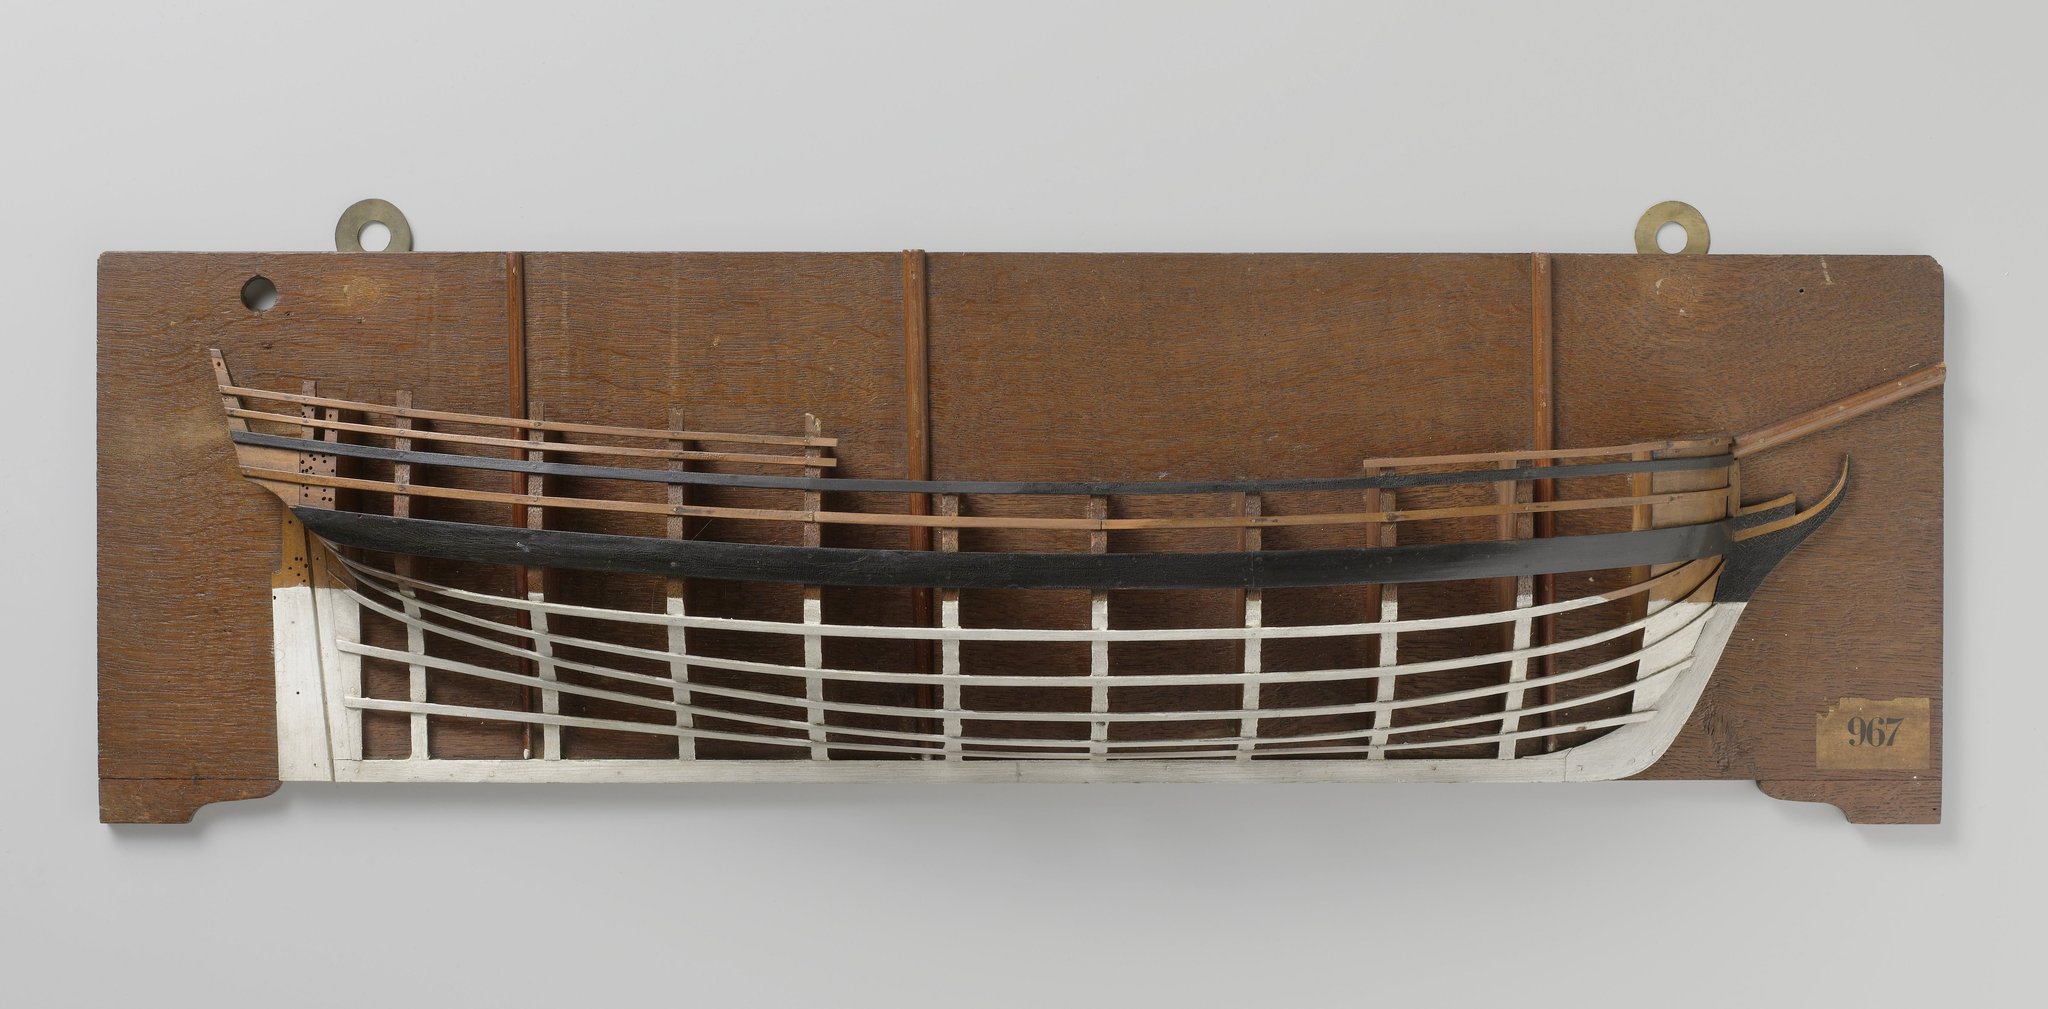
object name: builder's model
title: Half Model of a Sloop of War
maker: Anonymous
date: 1780-1820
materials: wood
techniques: polychromy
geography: netherlands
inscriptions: label, bottom right: ‘967’ former inventory label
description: Mallenmodel (stuurboord) van een driemaster. Geen geschutpoorten en geen dekken aangegeven. Gewrongen spiegel, hol wulf, geen details van hek of zijgalerij; recht roer met vierkante roerkoning. Zeeg naar voren en naar achter oplopend, één barkhout en één reehout. Gepiekt rondspant.